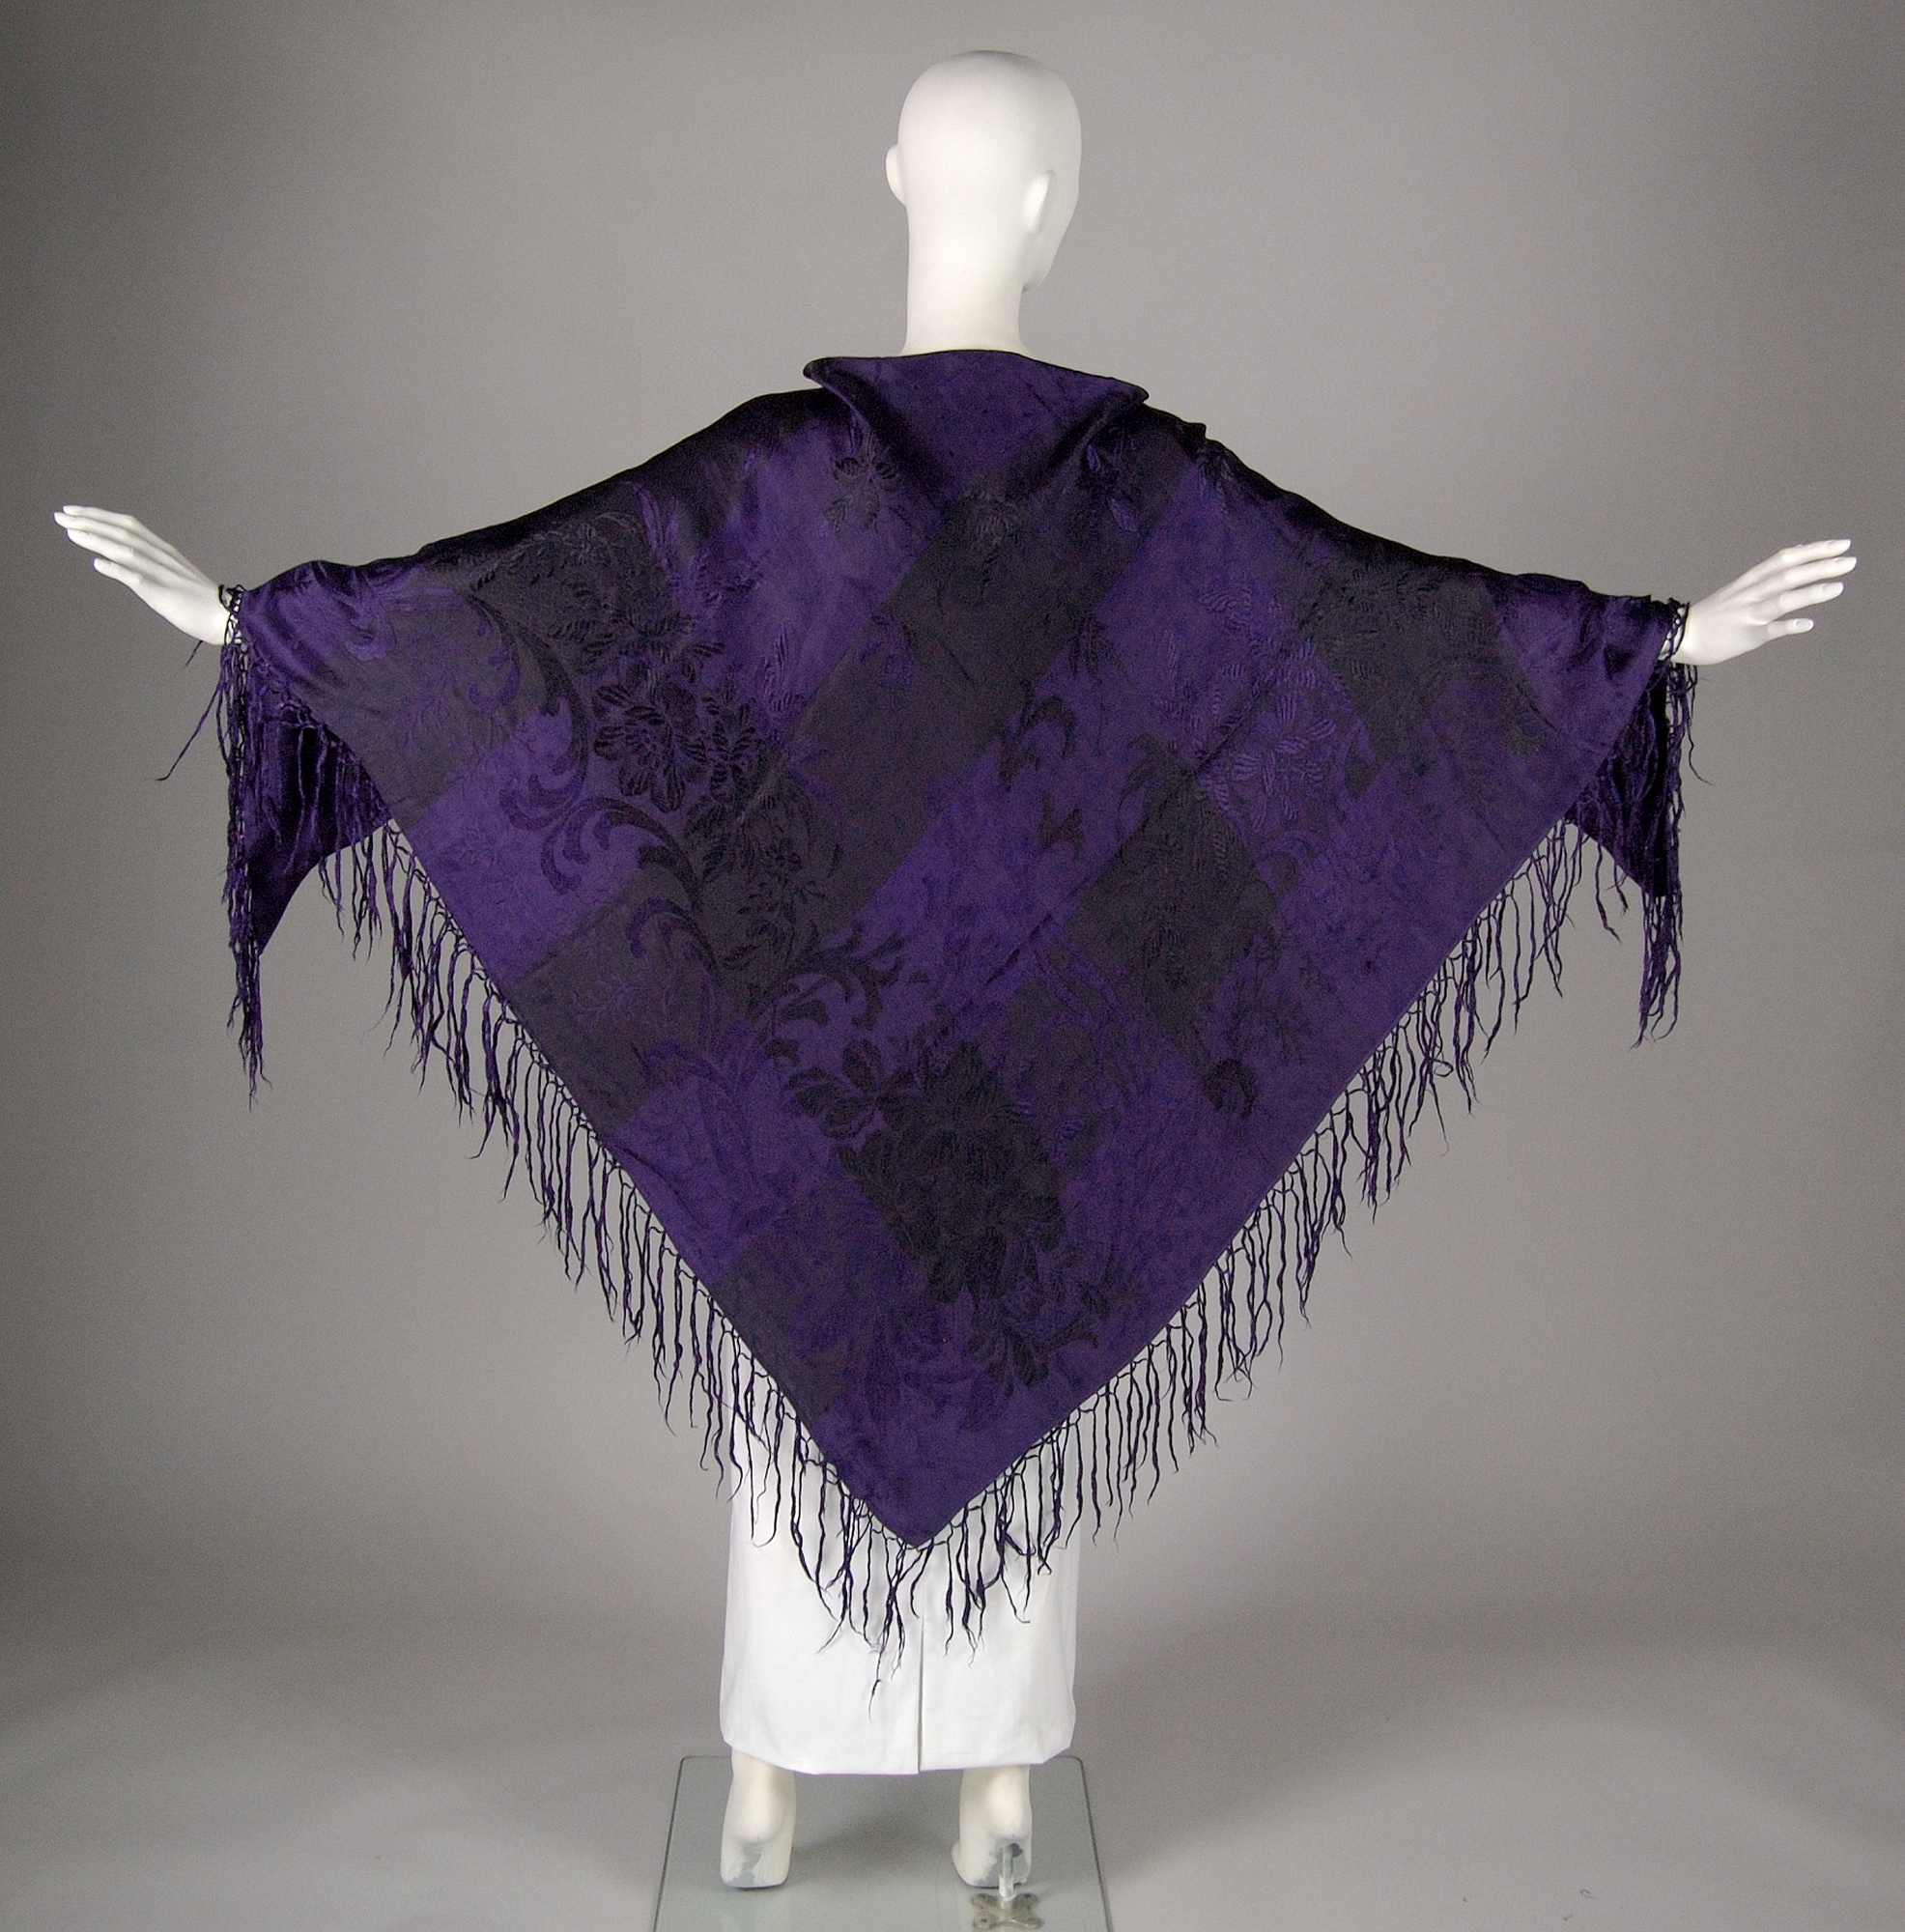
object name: mourning shawl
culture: american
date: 1840-1860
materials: silk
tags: flowers